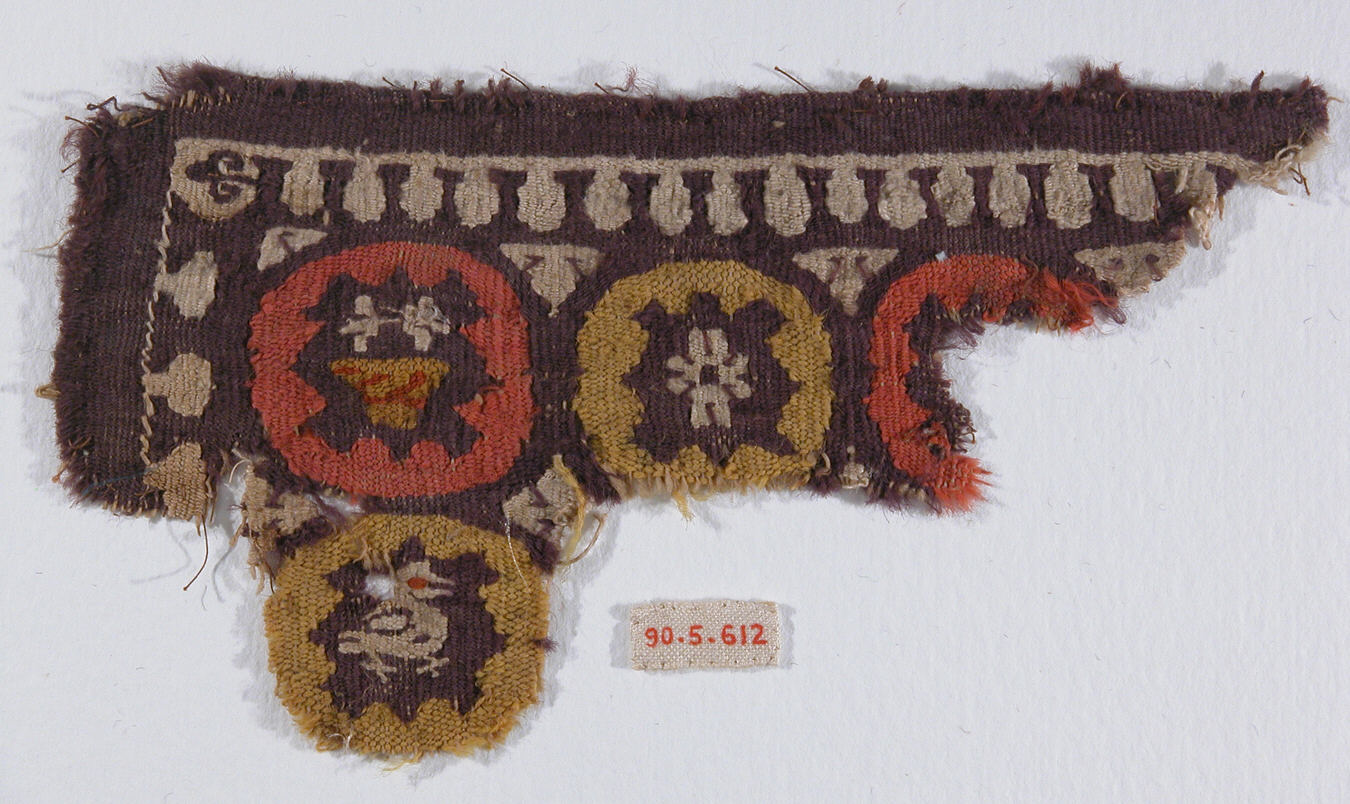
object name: textile fragment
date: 201-400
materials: linen, wool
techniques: weave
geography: egypt